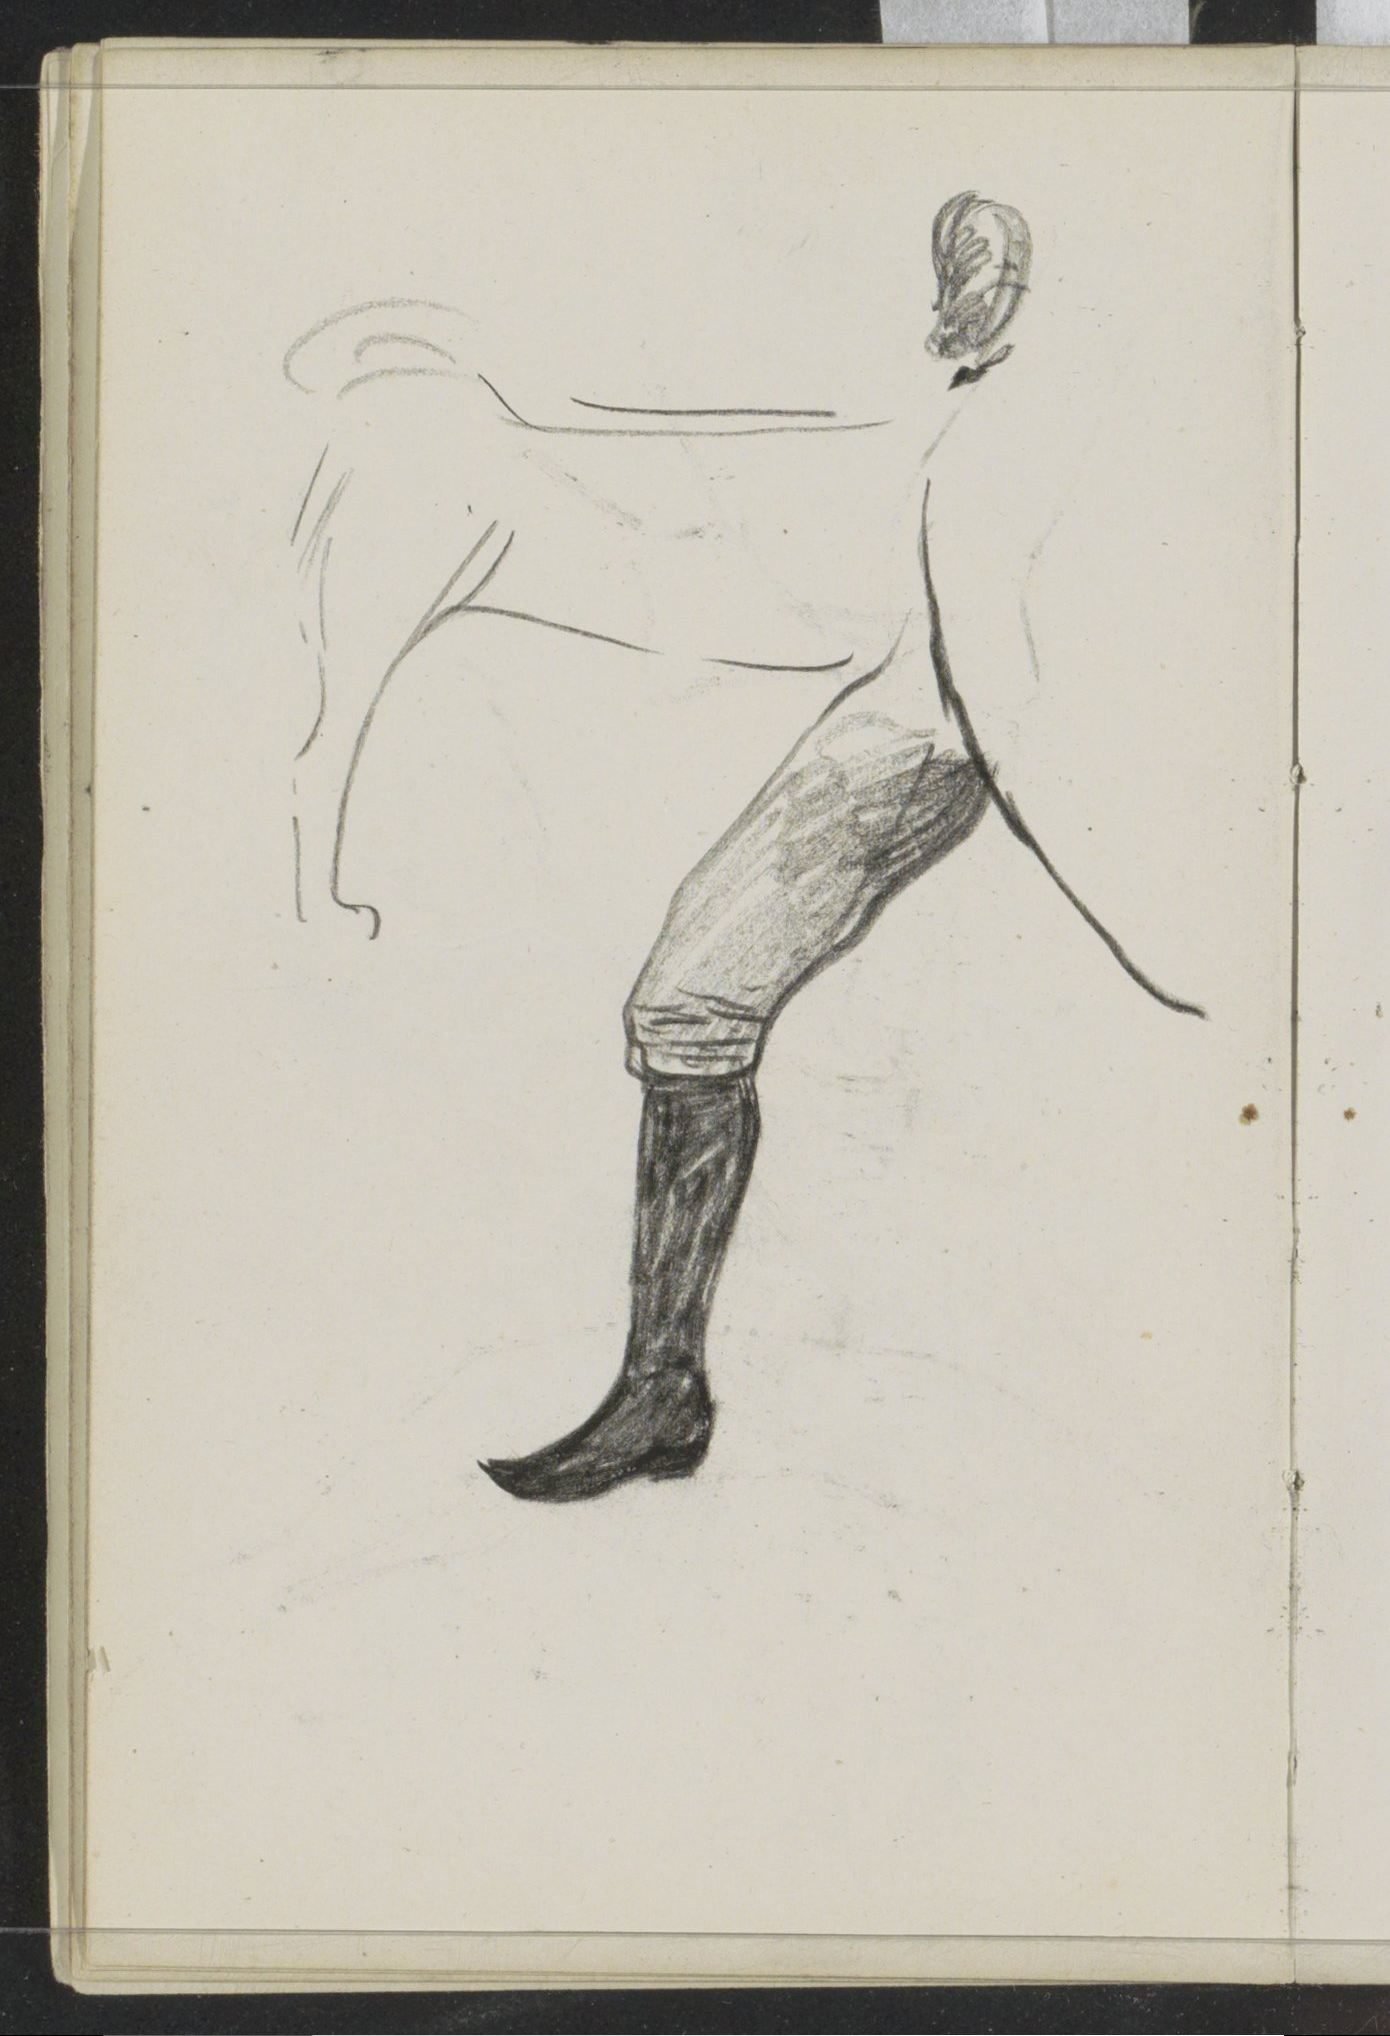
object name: sketchbook leaf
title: Been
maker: carel adolph lion cachet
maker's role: draughtsman, print maker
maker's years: 1864-1945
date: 1874-1945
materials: chalk, paper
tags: animals, legs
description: Tevens een studie van een dier. Blad 19 verso uit een schetsboek met 41 bladen.